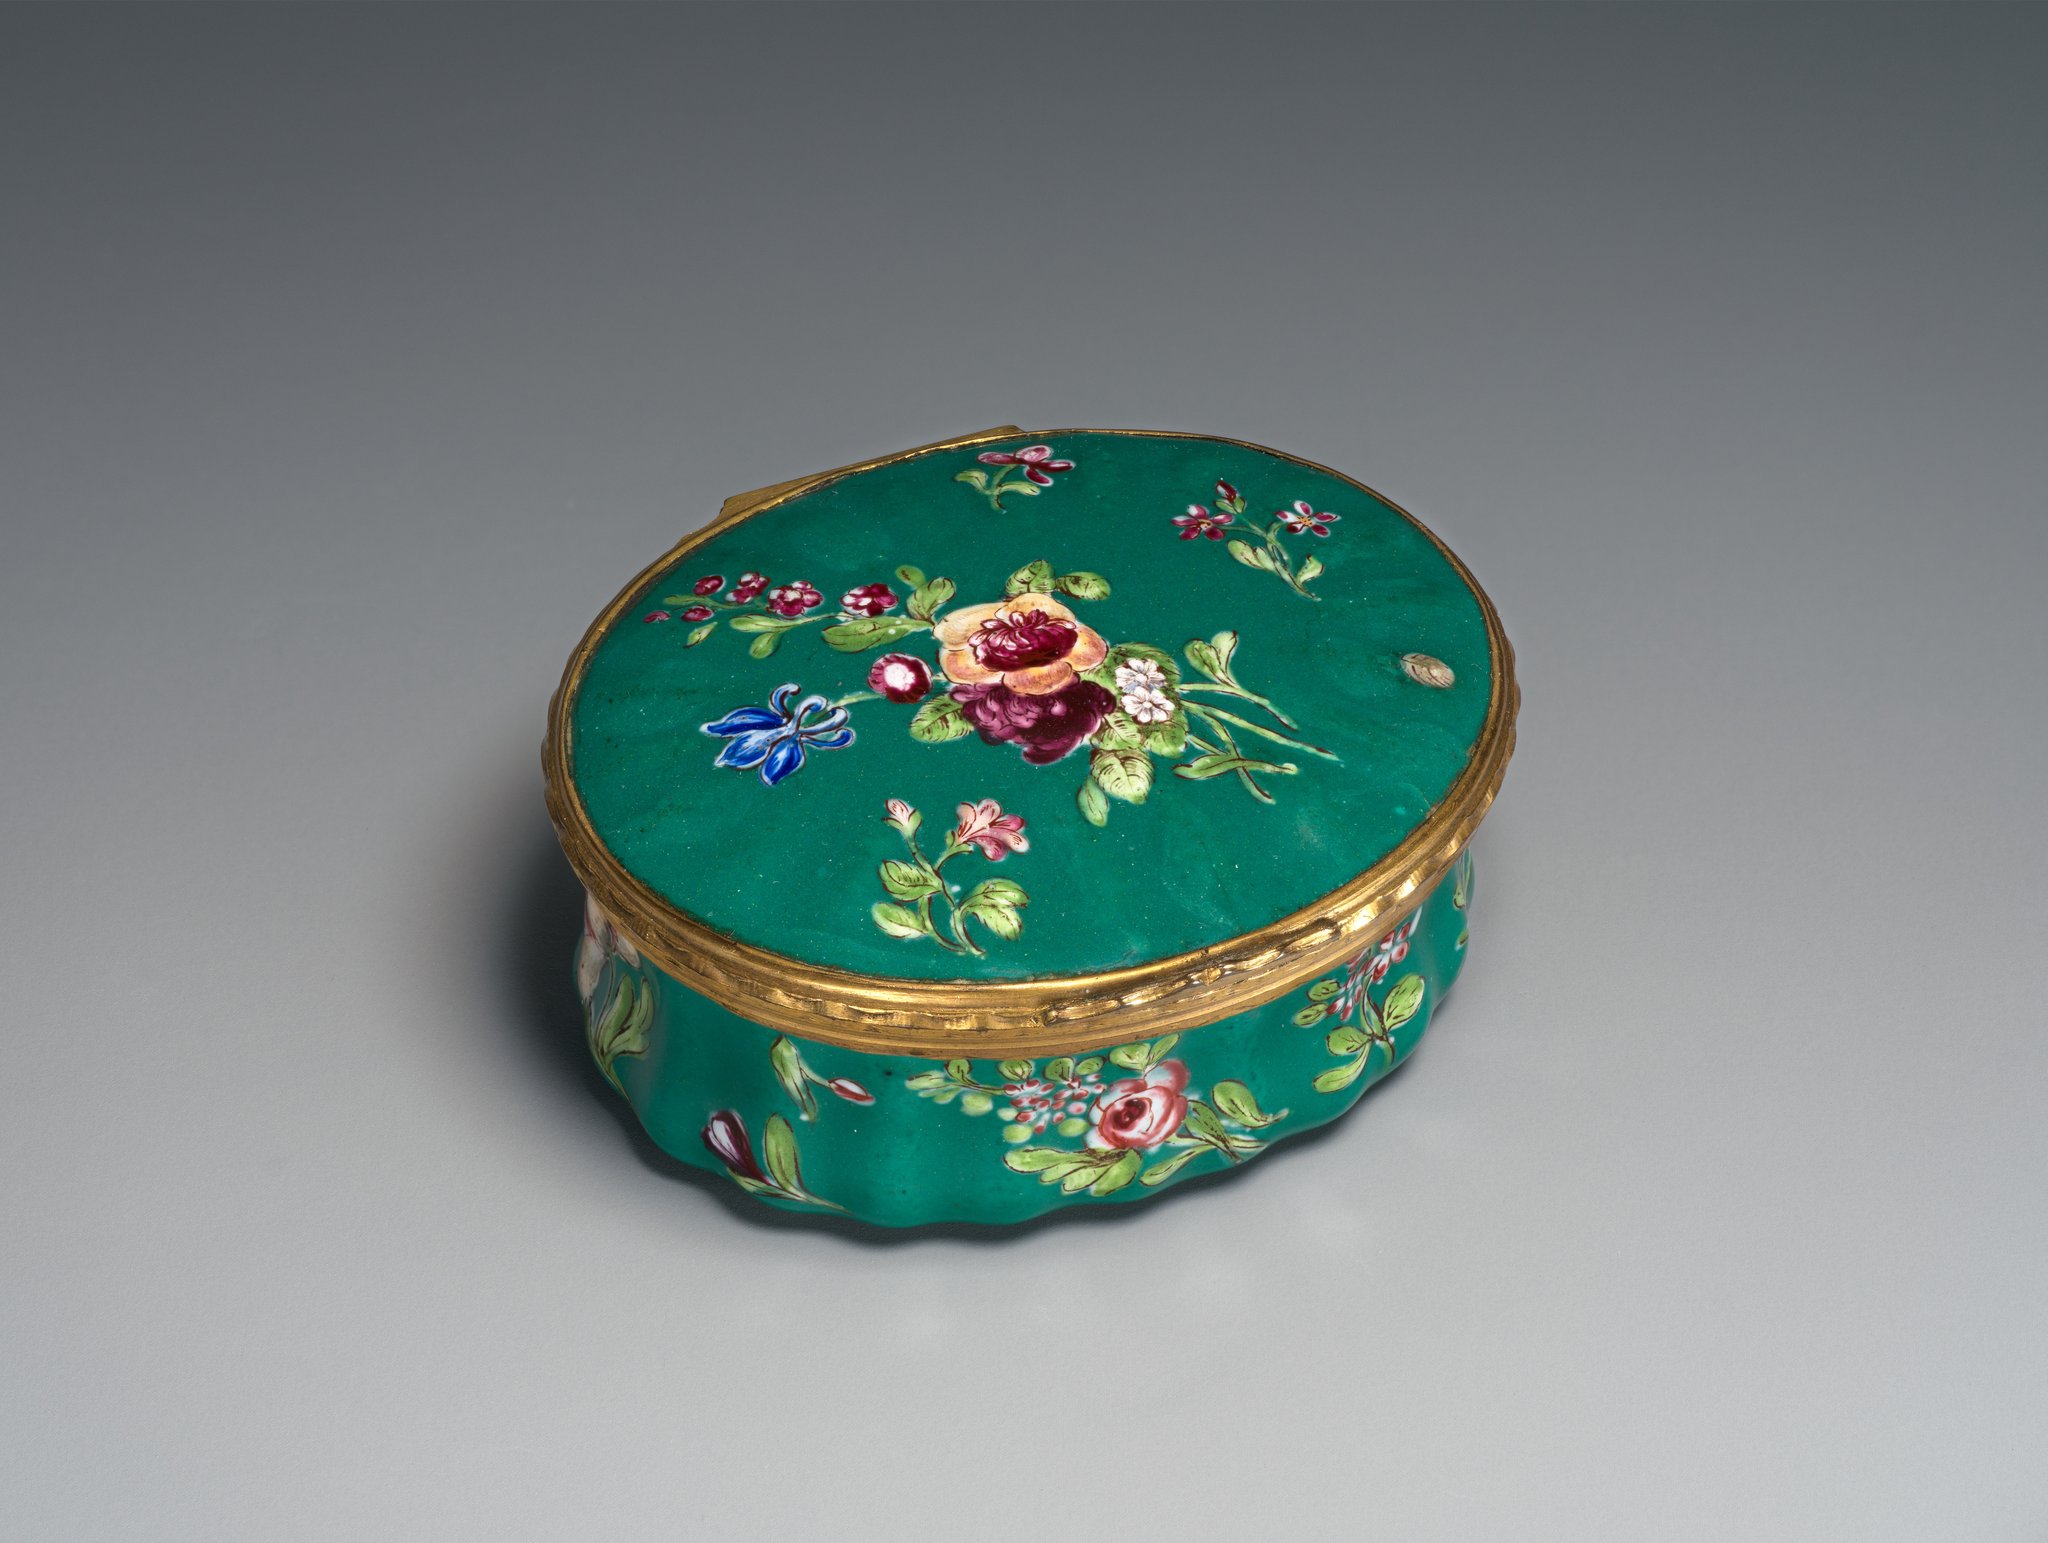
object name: snuffbox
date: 1750-1759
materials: copper, enamel